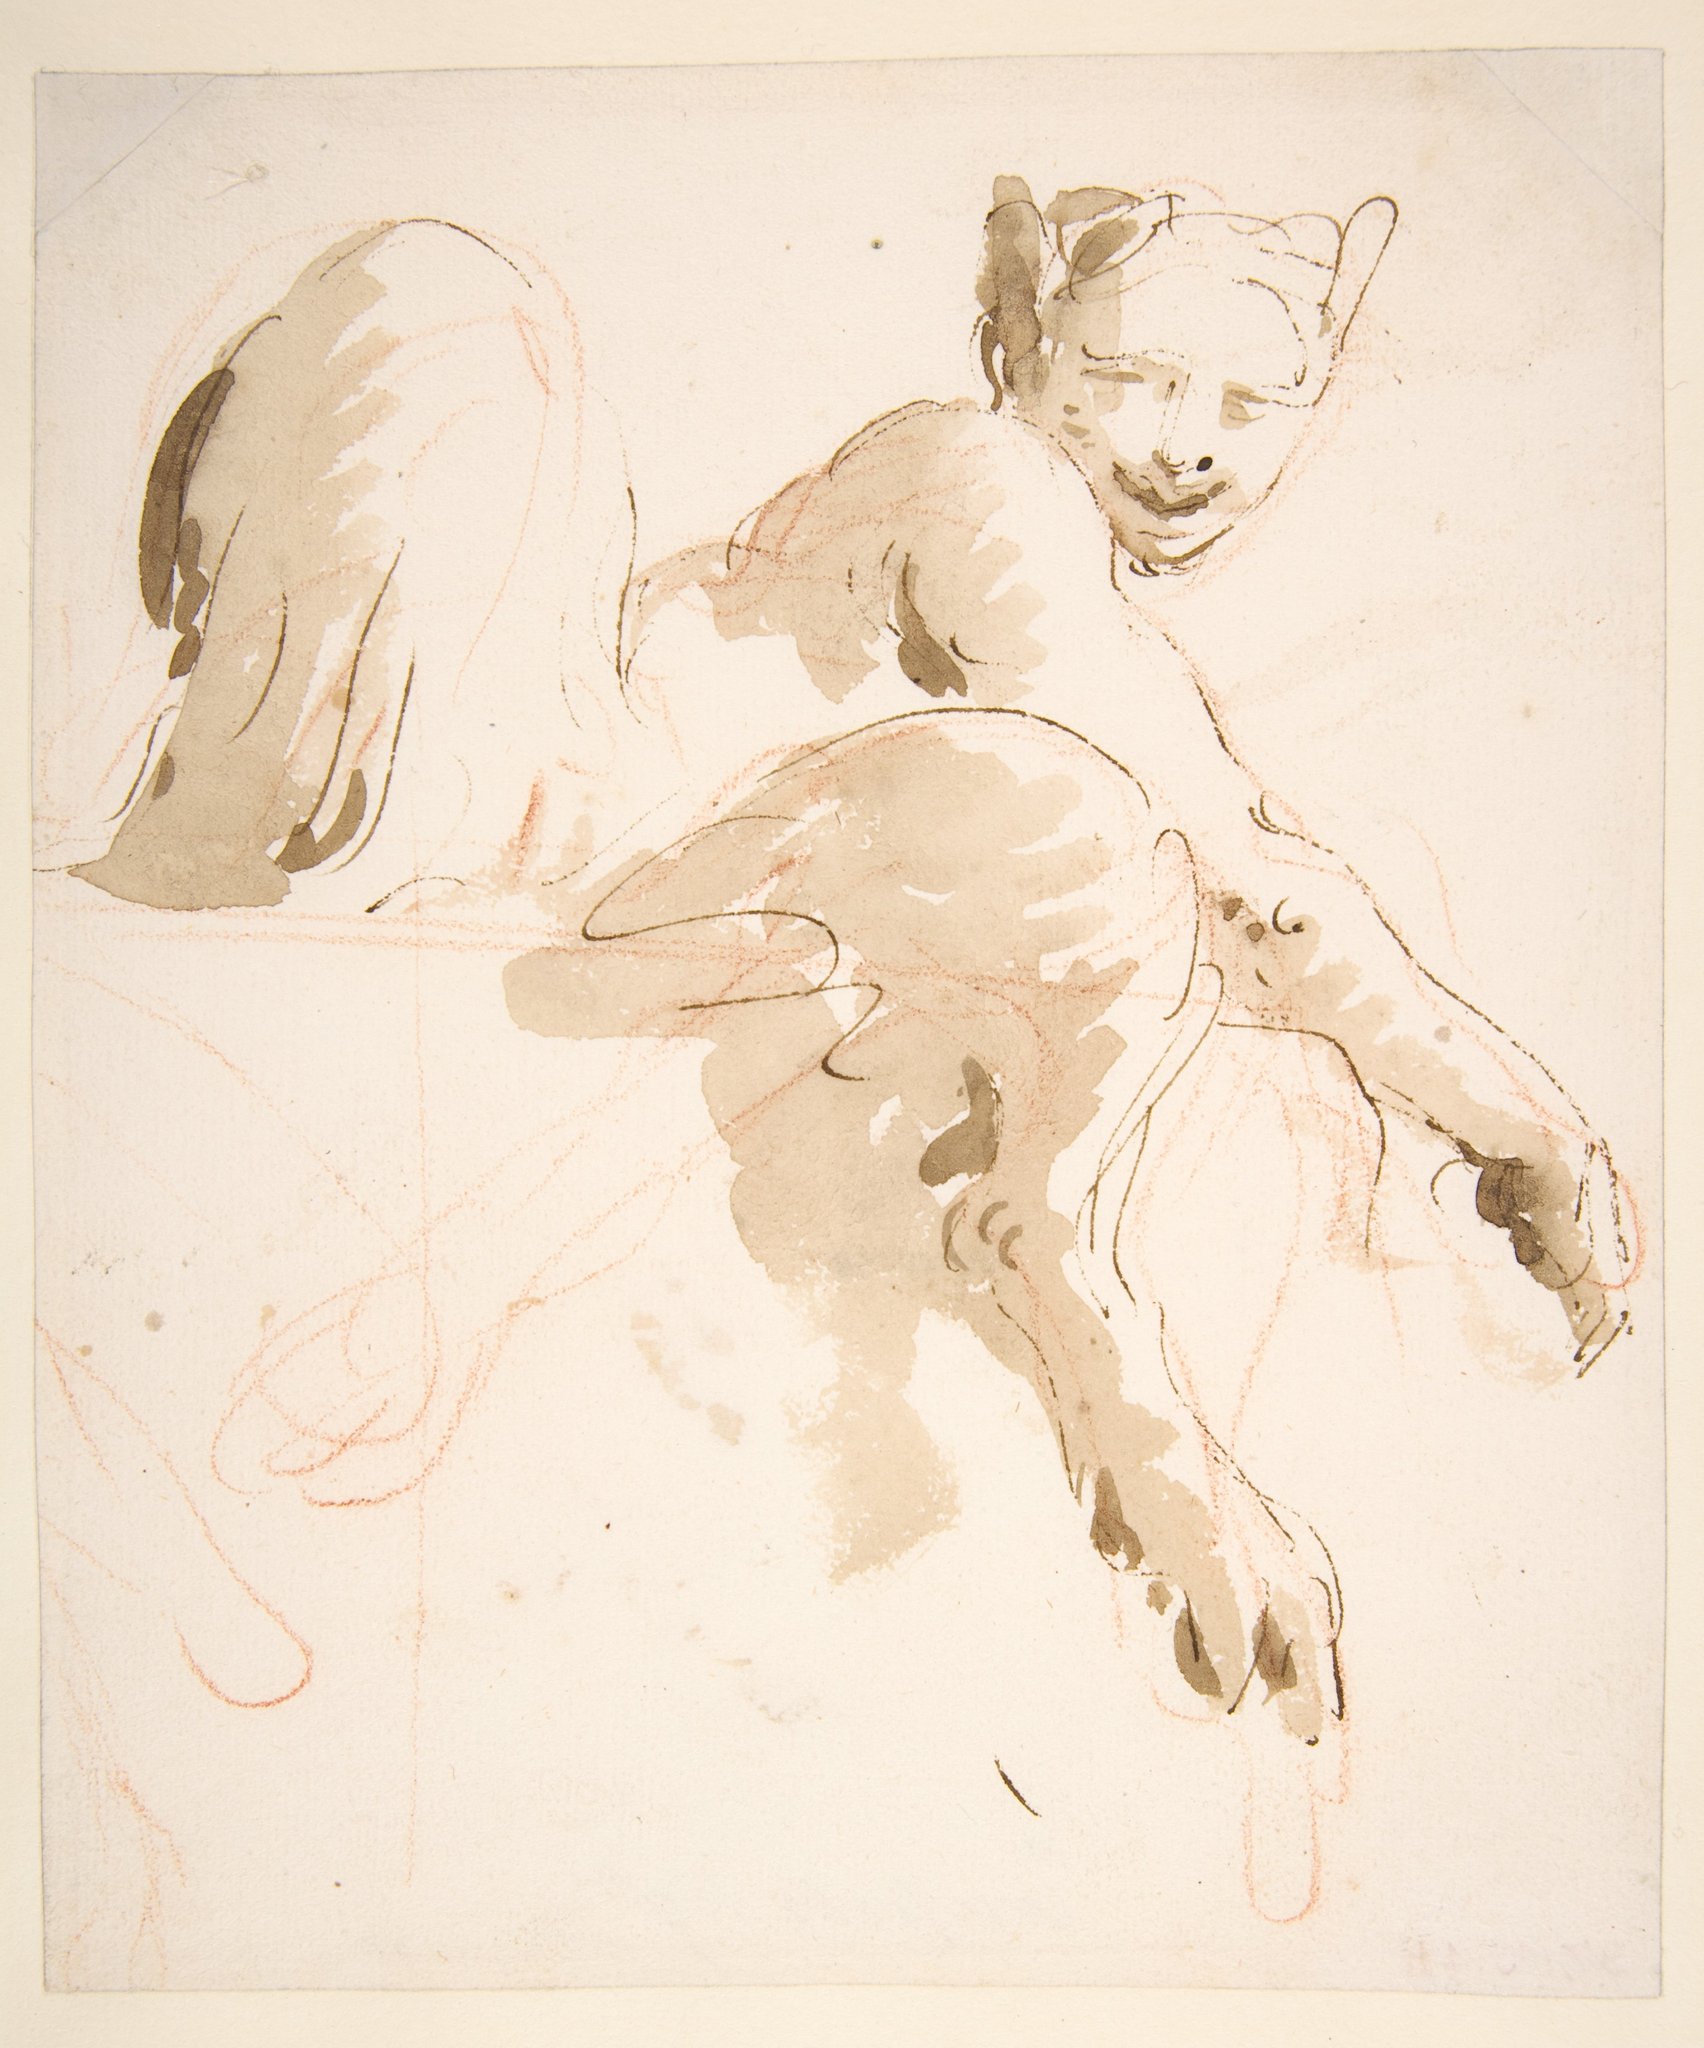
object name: drawing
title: Seated Satyress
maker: giovanni battista tiepolo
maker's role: artist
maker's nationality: italian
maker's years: 1696-1770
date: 1696-1770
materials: chalk, ink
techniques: brush, pen, wash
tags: satyrs